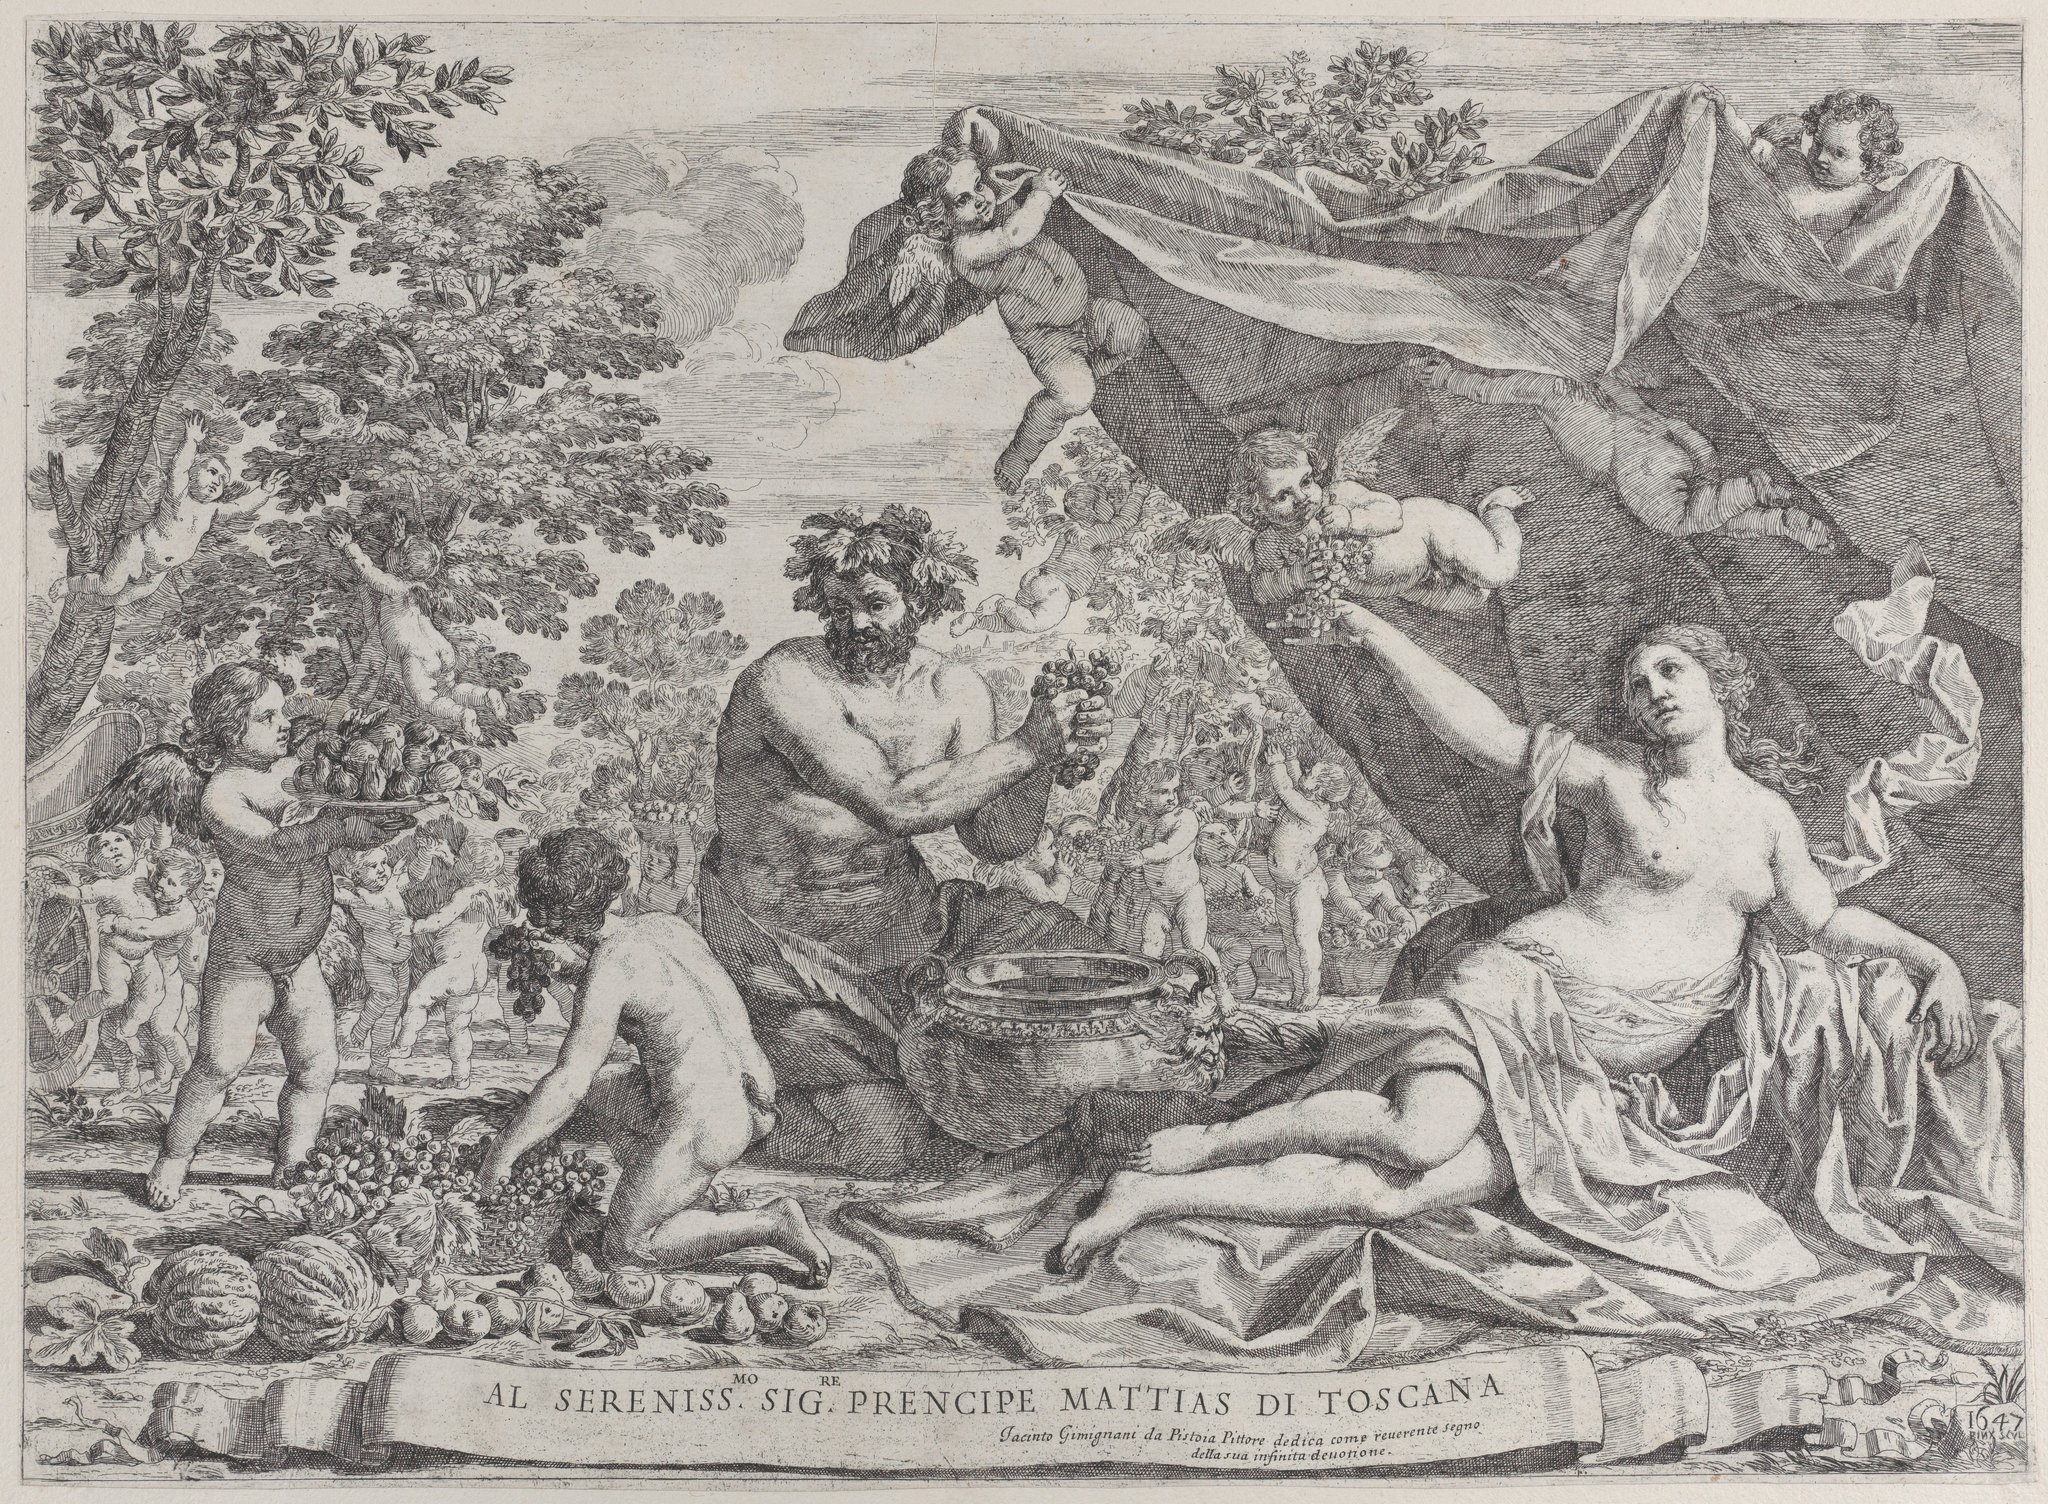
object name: print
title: Garden of Venus with Bacchus Squeezing Grapes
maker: giacinto gimignani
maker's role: artist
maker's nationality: italian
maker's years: 1606-1681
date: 1647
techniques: etching